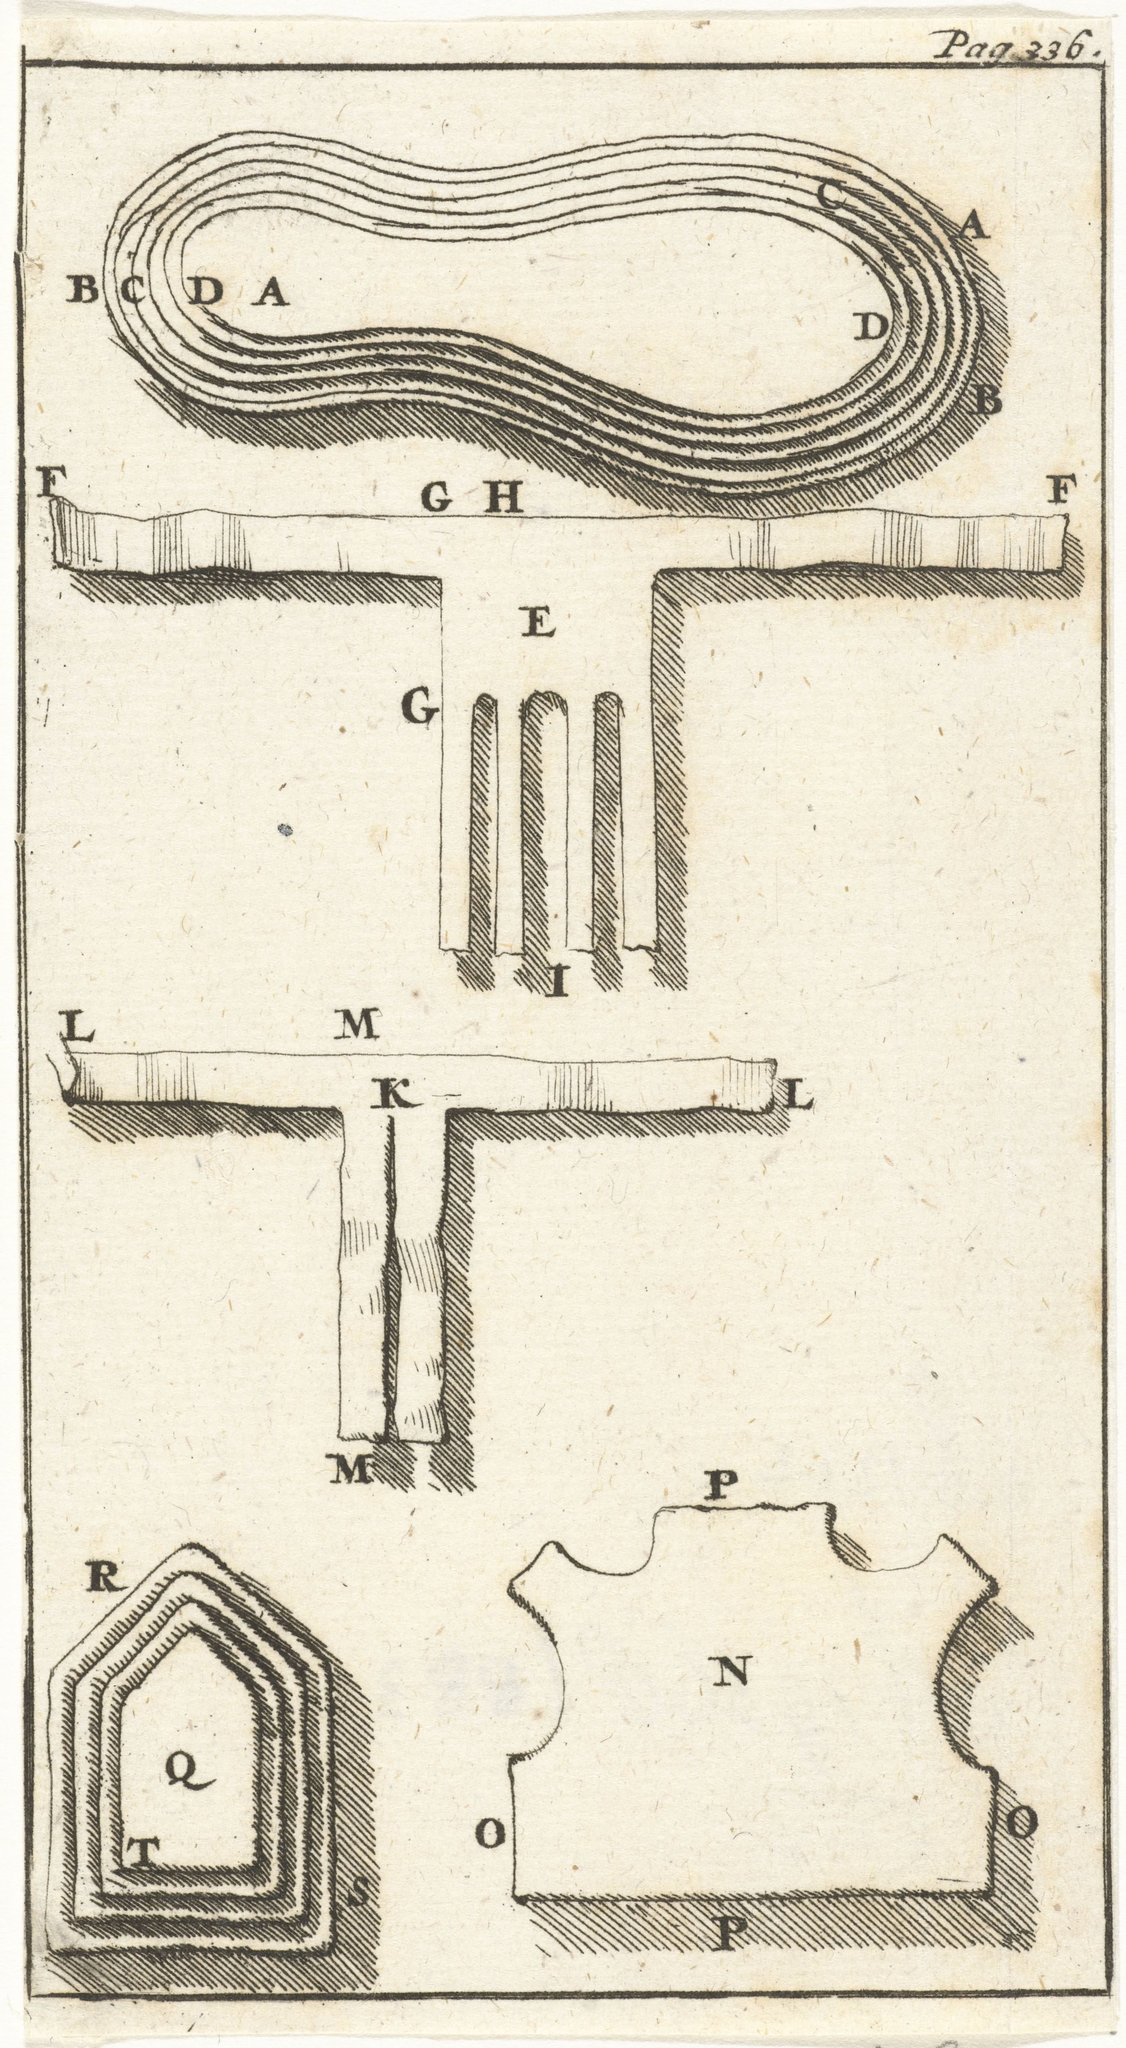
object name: print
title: Weergave van verschillende verbanden A-T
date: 1691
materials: paper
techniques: etching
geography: amsterdam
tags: dressing, bandage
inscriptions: collector's mark: Lugt 2228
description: Illustratie uit: Verduc, Laurent. Het Parische verband-huis, waarin getoont werd, de wyse om alle fracturen en luxatien (...) te genesen. Amsterdam: Jan Claesz ten Hoorn, 1691.